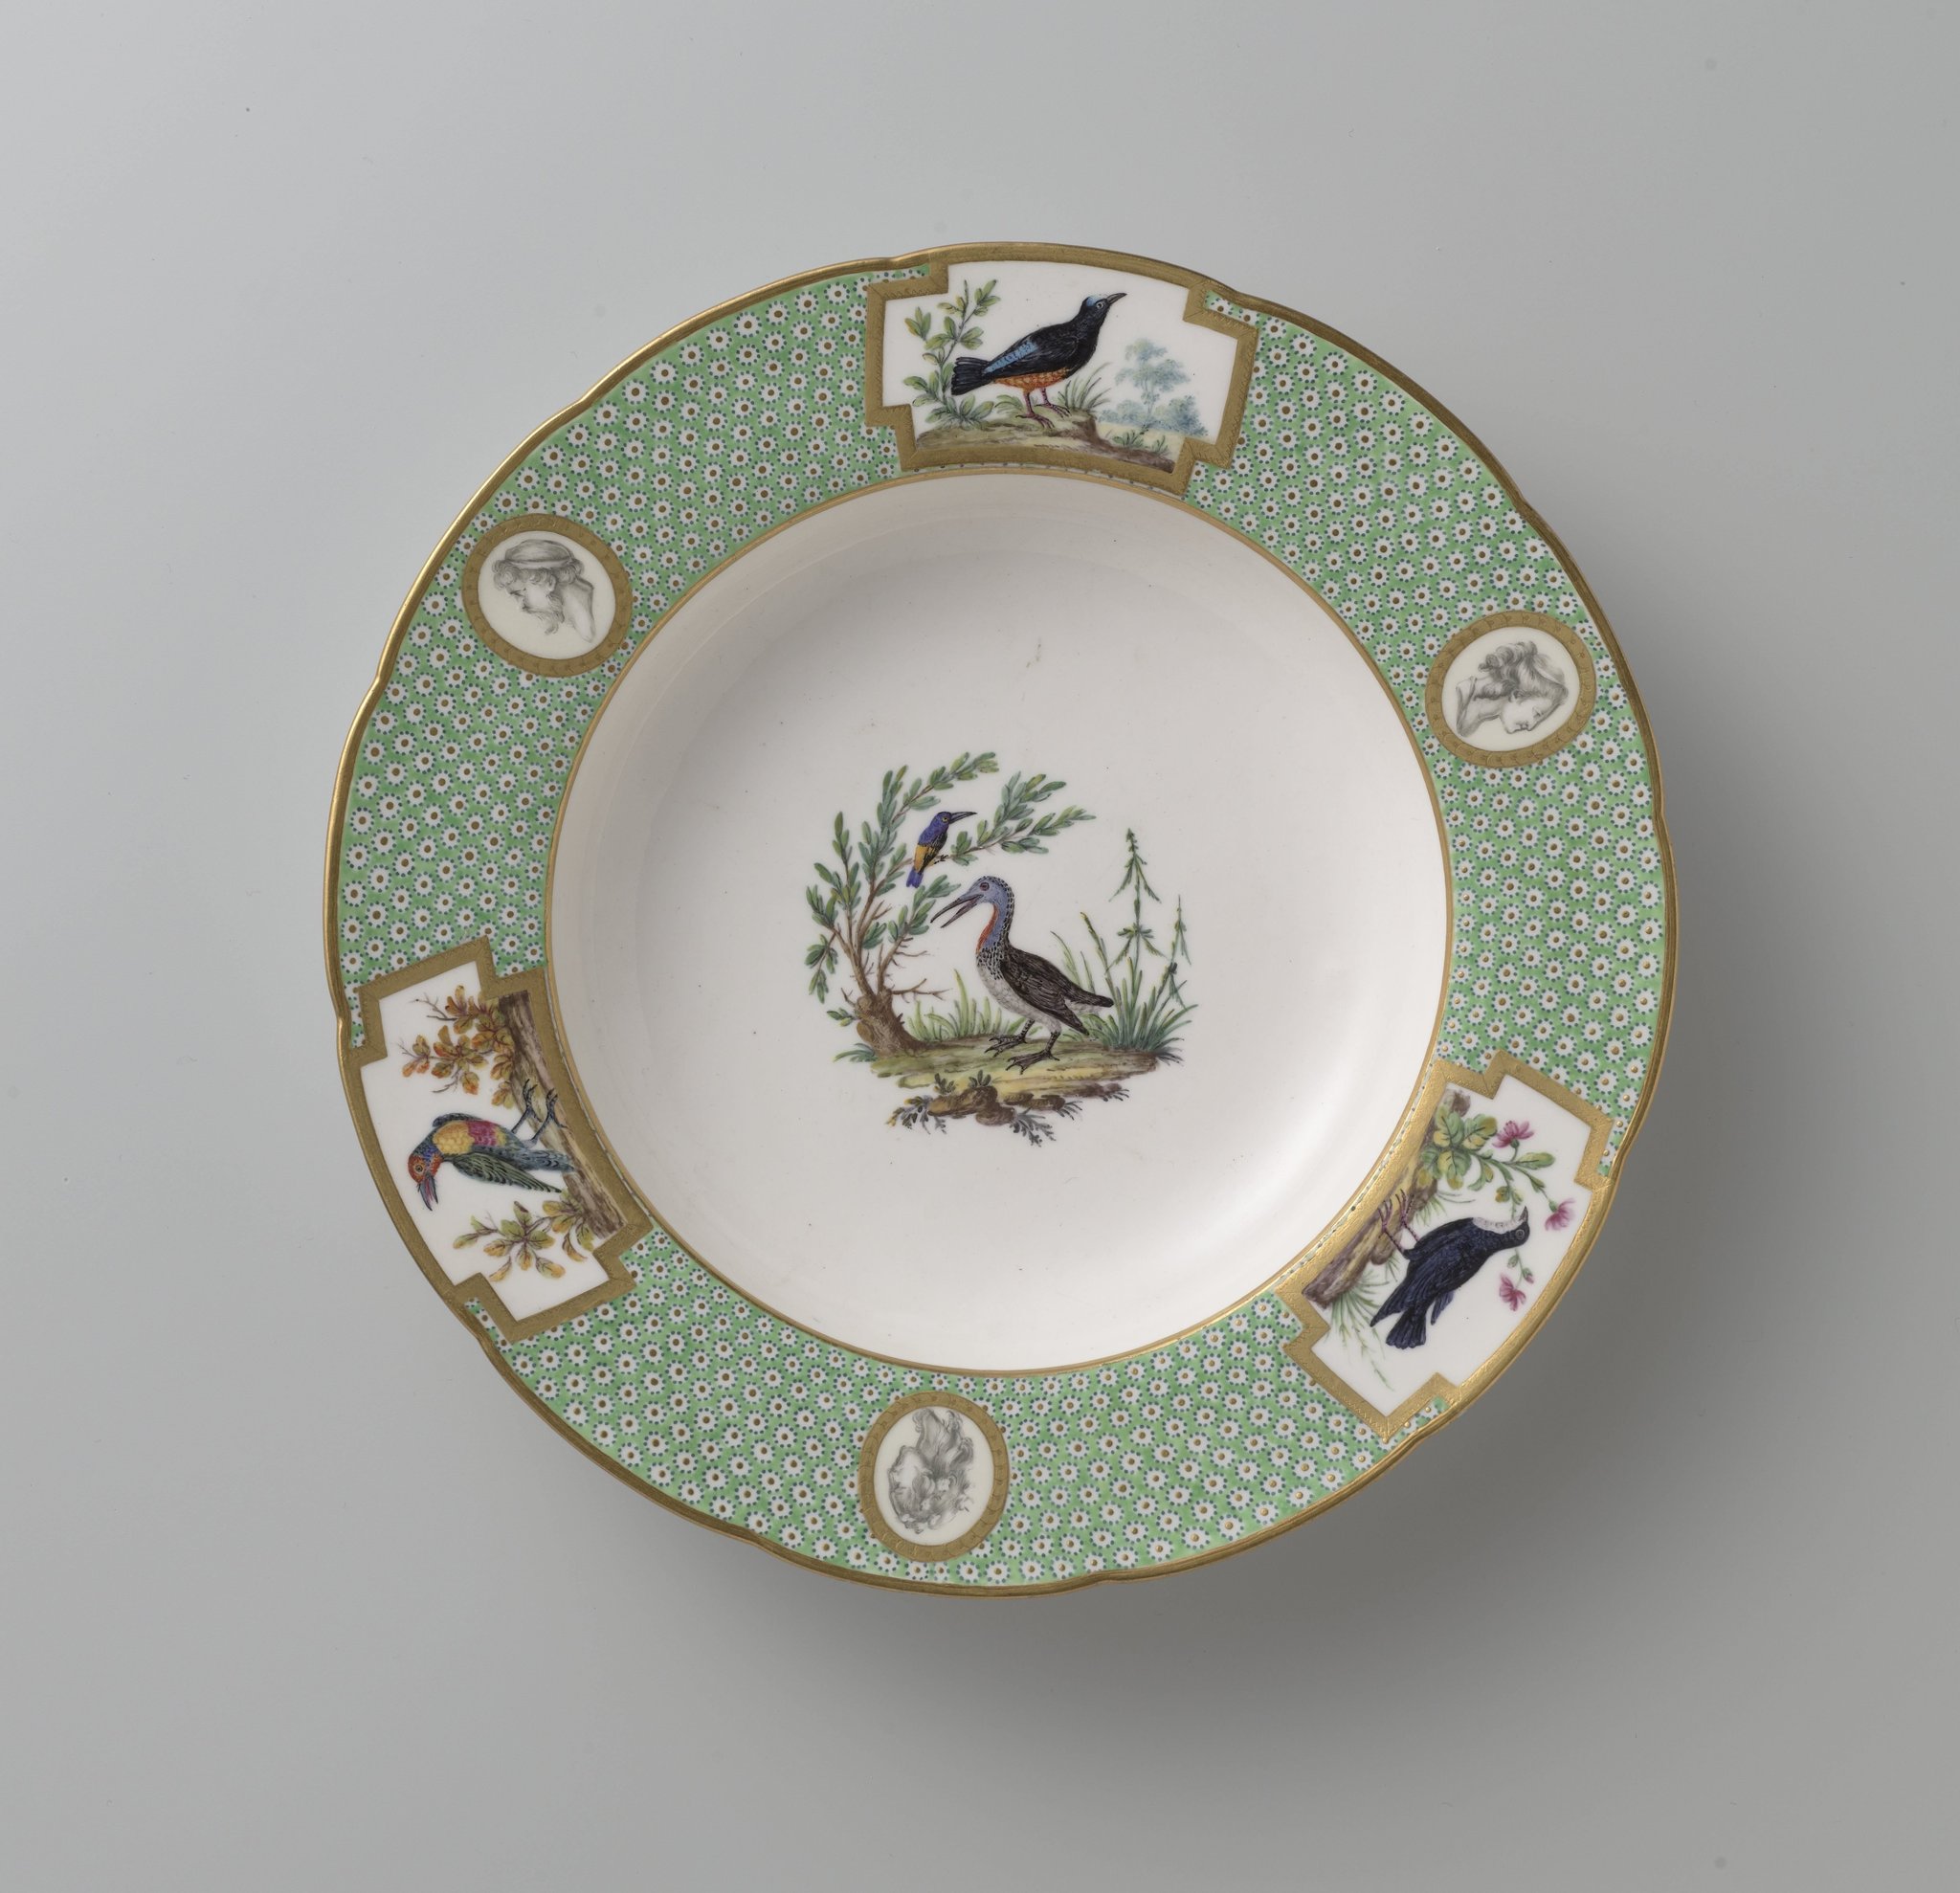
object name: plate dish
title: Soup plate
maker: henry-françois vincent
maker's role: vergulder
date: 1784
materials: porcelain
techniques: gilding, painted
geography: sèvres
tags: birds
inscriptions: mark: ‘2000’, mark: ‘24’, factory mark: ‘gekruiste LL met jaarletter gg’, inscription: ‘Manakin à front blanc/ de Cayenne, Barbu de Maynas, Mankin à gorge blanche’, inscription: ‘Plongeon à gorge,/ rouge, de Cayenne’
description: This soup plate is part of a large and very expensive service that was ordered from Sèvres by the French dealer Lefèvre, who delivered it to a Dutch client. Lefèvre bought large quantities of porcelain from the Sèvres factory between 1780 and 1788. He generally sold the porcelain through the shop run by his father and brother in Amsterdam.